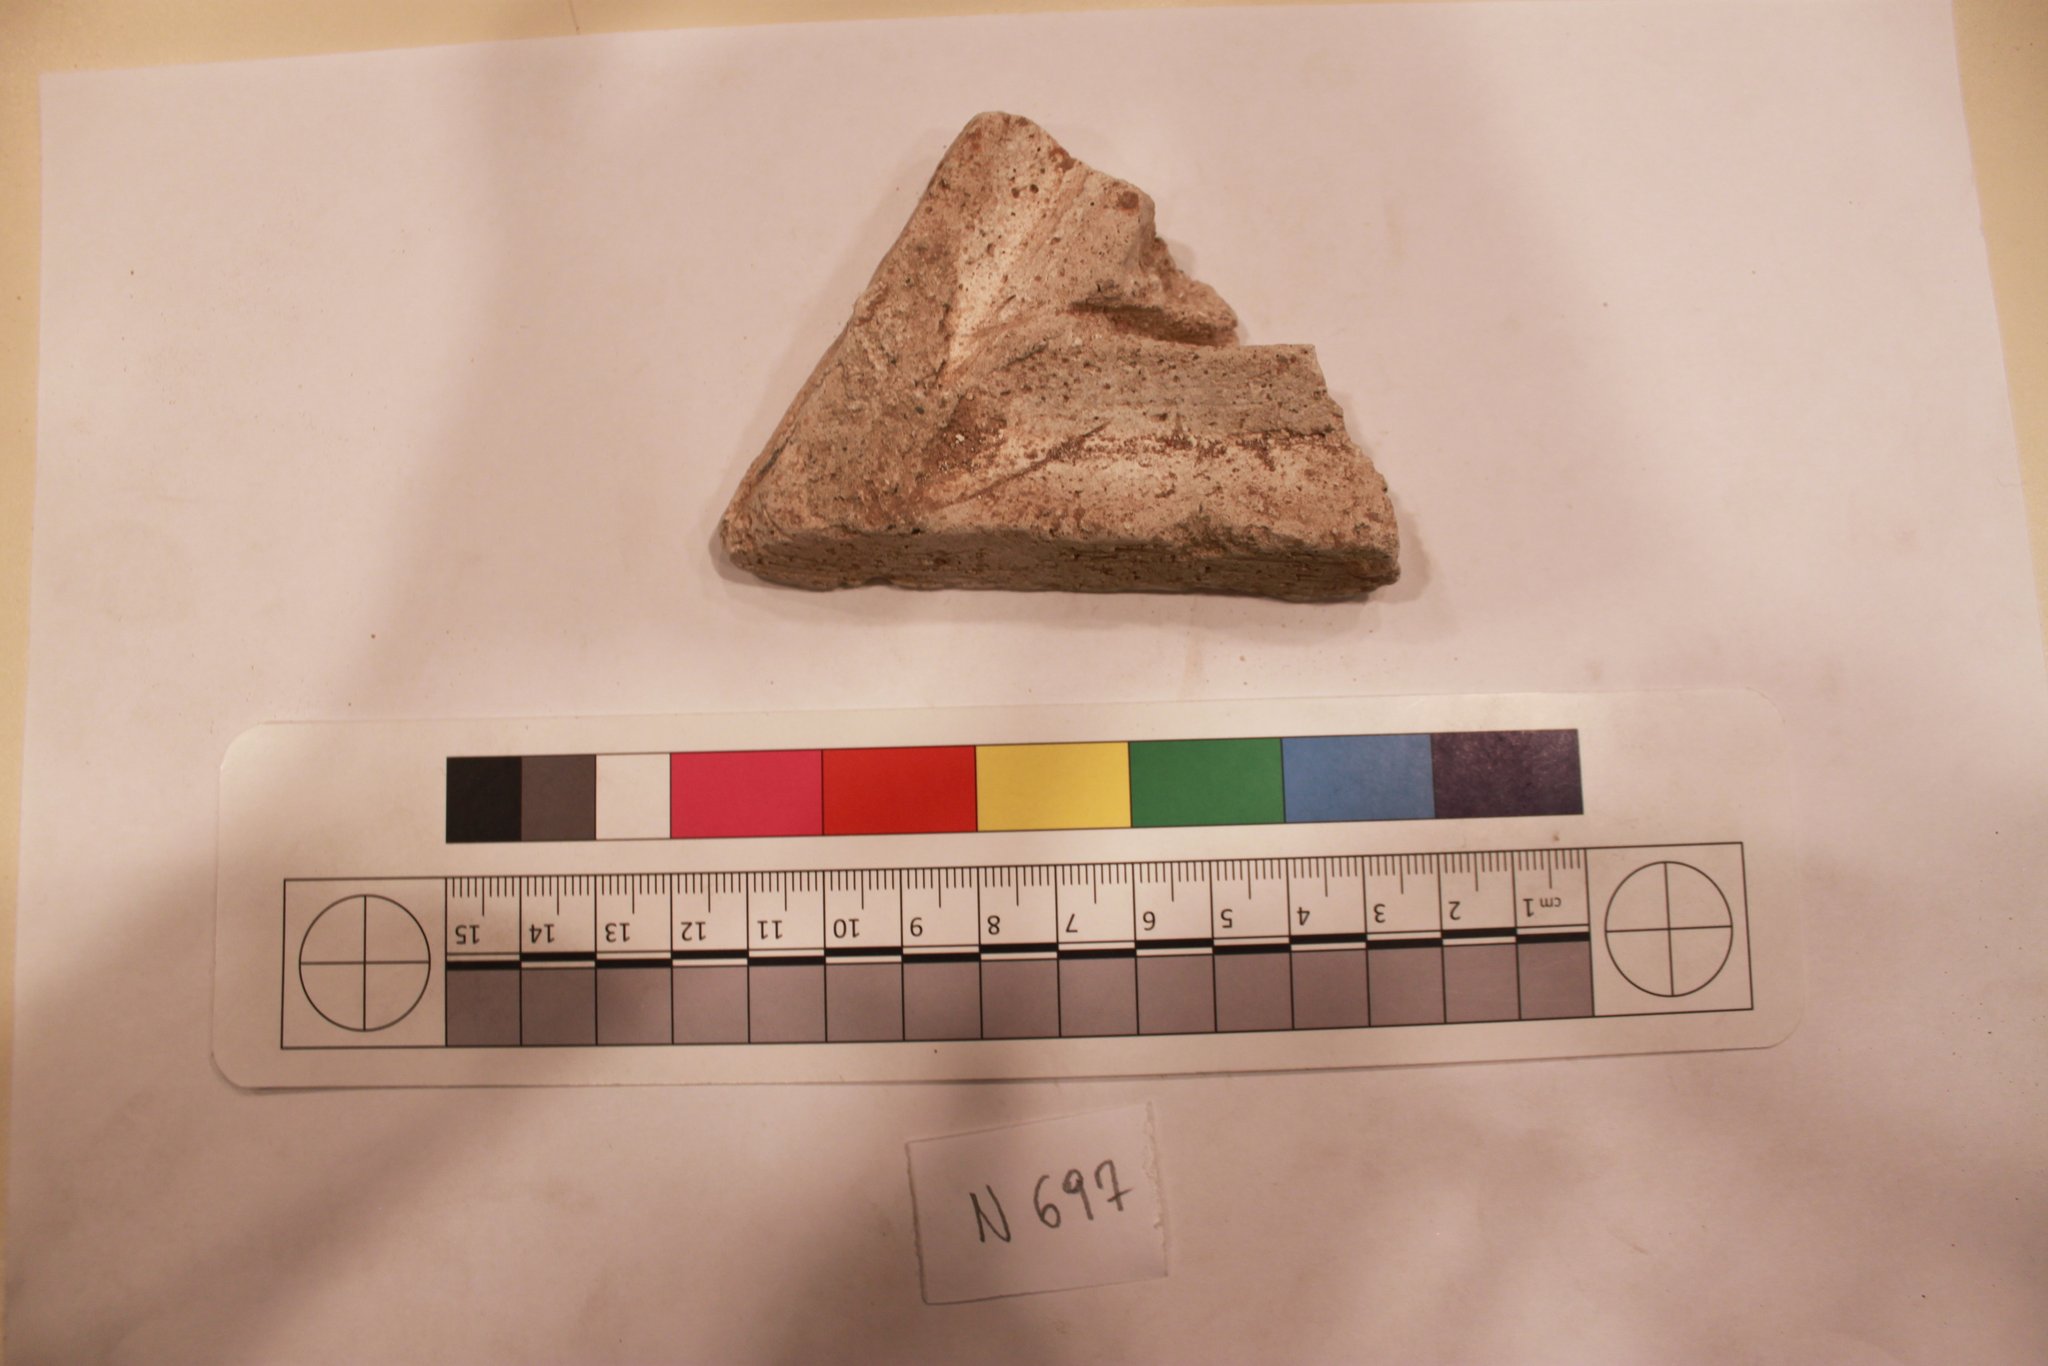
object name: fragment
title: Stucco Fragment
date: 701-1200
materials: plaster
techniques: carving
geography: iran